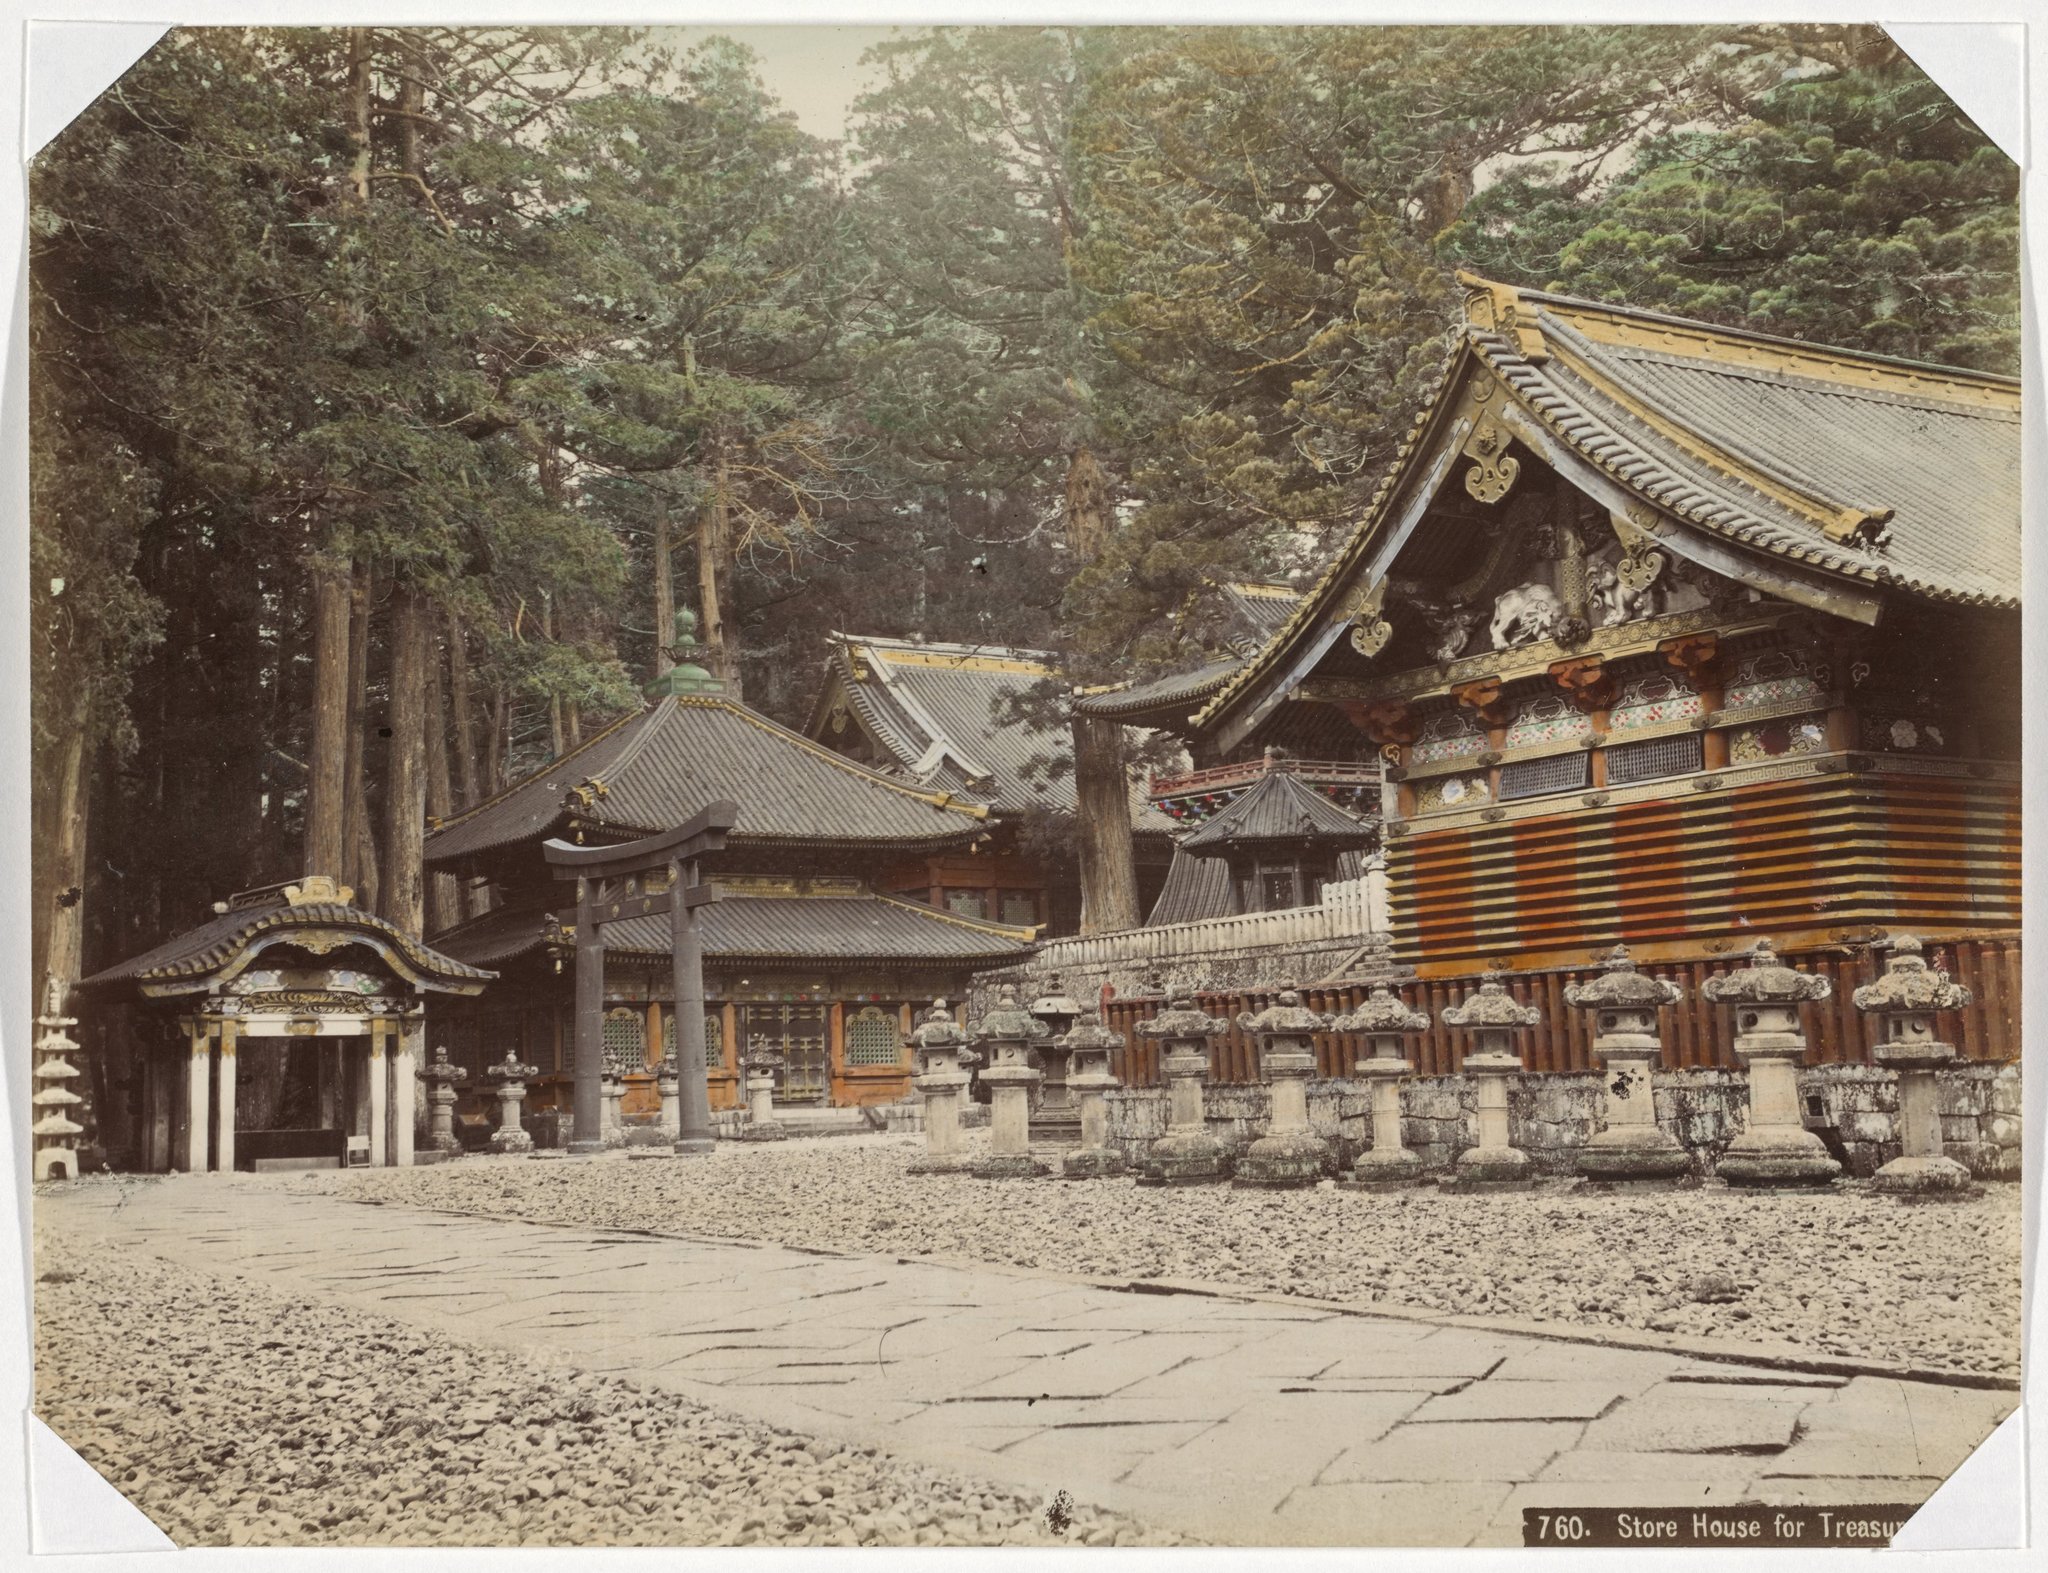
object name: photograph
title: Store House for Treasures Nikko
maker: Anonymous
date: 1890-1894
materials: cardboard, paper, photographic support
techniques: albumen print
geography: nikko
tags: temple, shrine ~ hinduism, buddhism, jainism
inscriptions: negative number: ‘760’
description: Onderdeel van Album met 69 foto's van een reis door Japan.